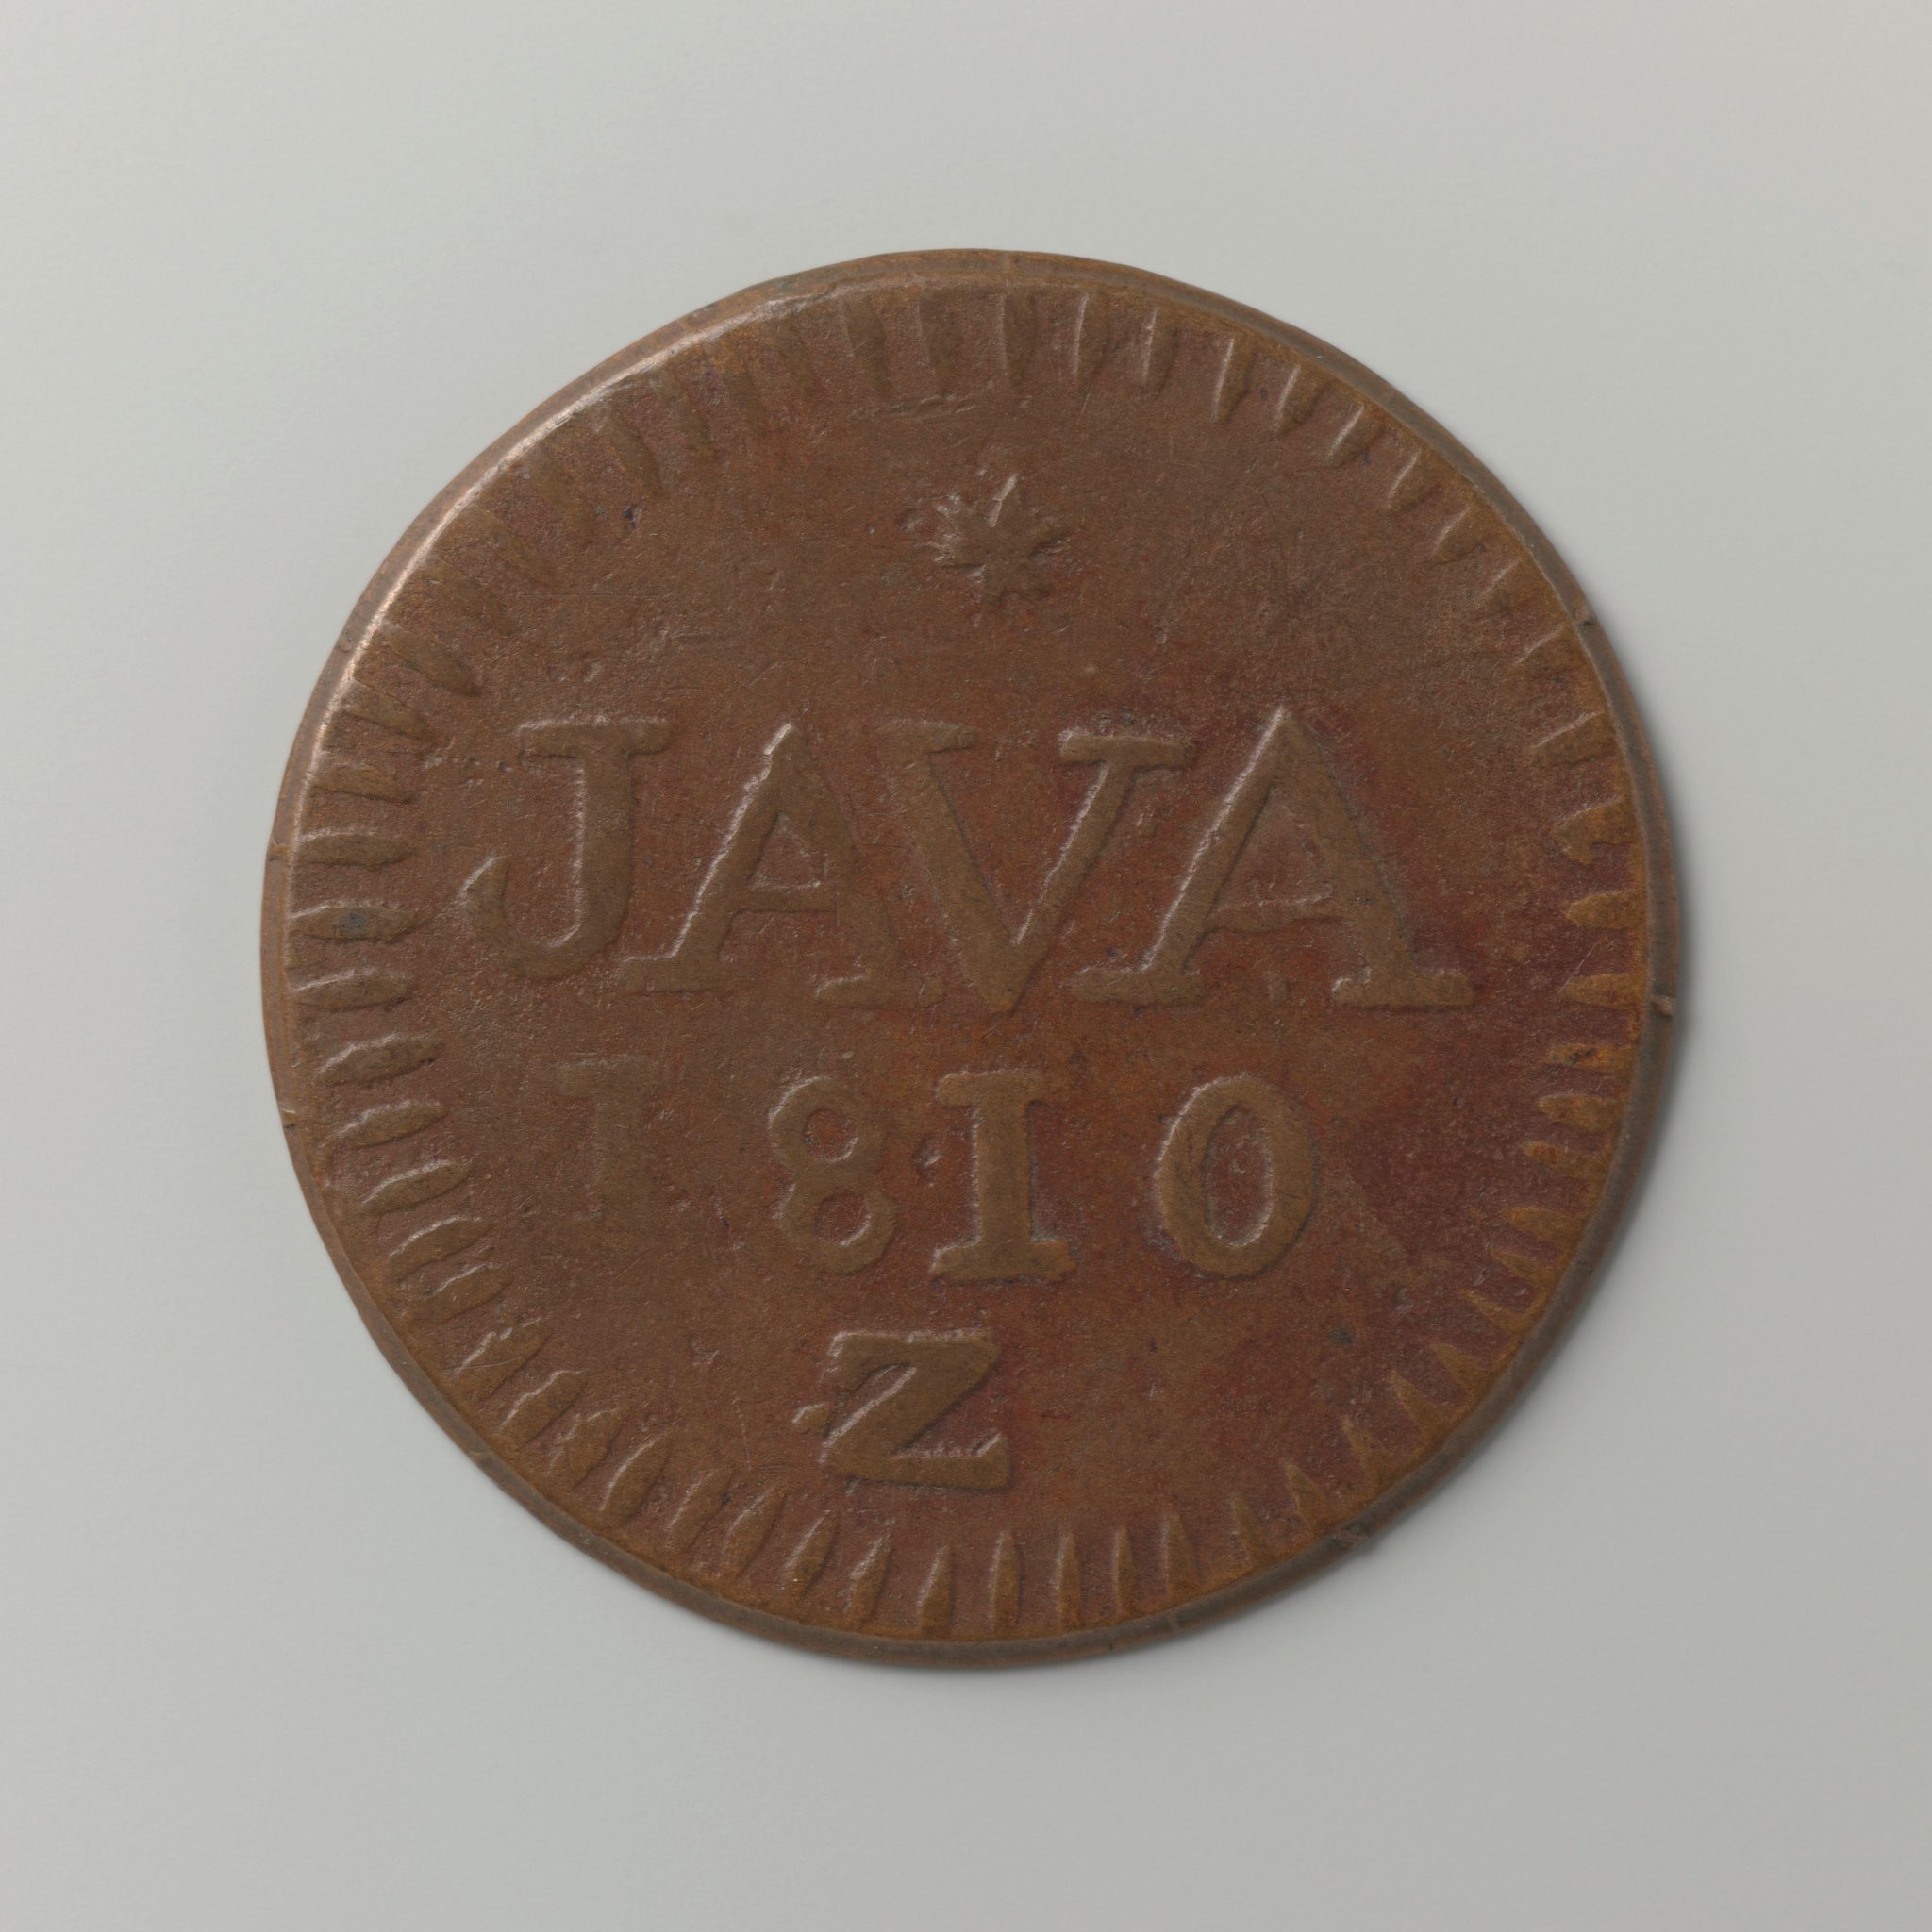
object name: coin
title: Nederlands Indië, ½ stuiver Java, 1810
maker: louis napoleon (king of holland)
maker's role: koning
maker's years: 1778-1846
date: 1810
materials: copper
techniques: striking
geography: surabaya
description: Koperen munt. Voorzijde: tussen waarde/aanduiding ½ St ineen gestrengelde initialen L en N van Lodewijk Napoleon. Daarboven muntteken. Keerzijde: eenregelig opschrift, waaronder jaartal. Boven opschrift muntteken en onder jaartal muntmeesterteken Z [=muntmeester Zwekkert].